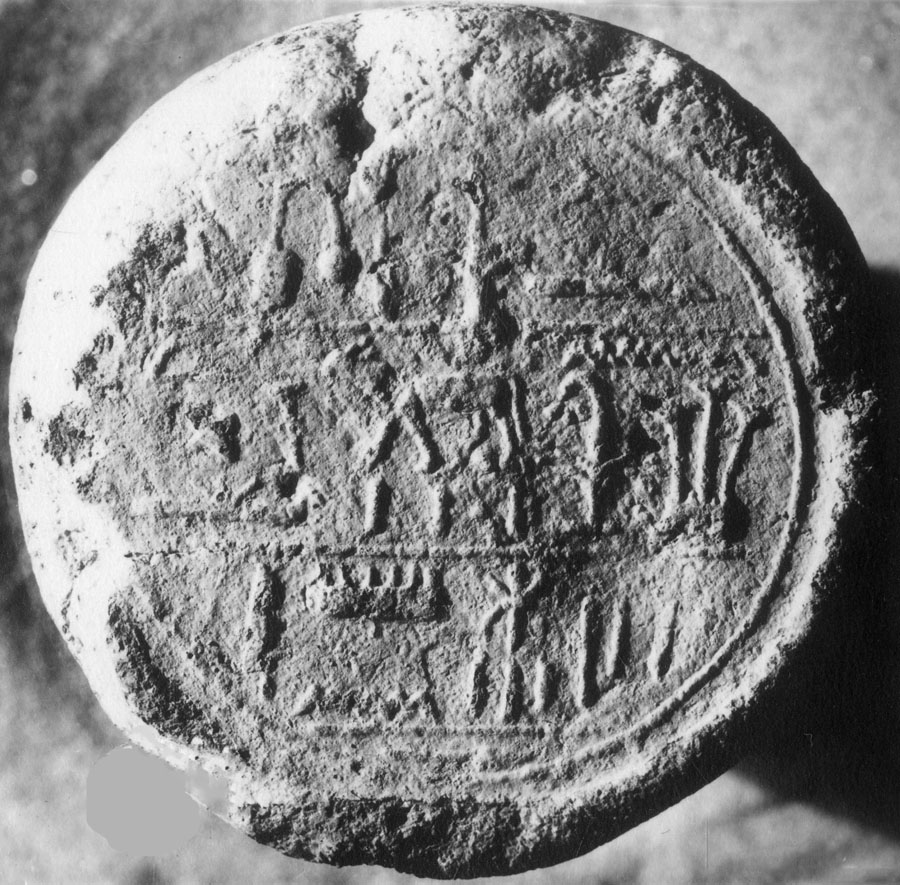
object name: cone, amenmose, round, royal scribe, cattle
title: Funerary Cone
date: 1550-1295 BCE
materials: pottery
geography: egypt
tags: hieroglyphs